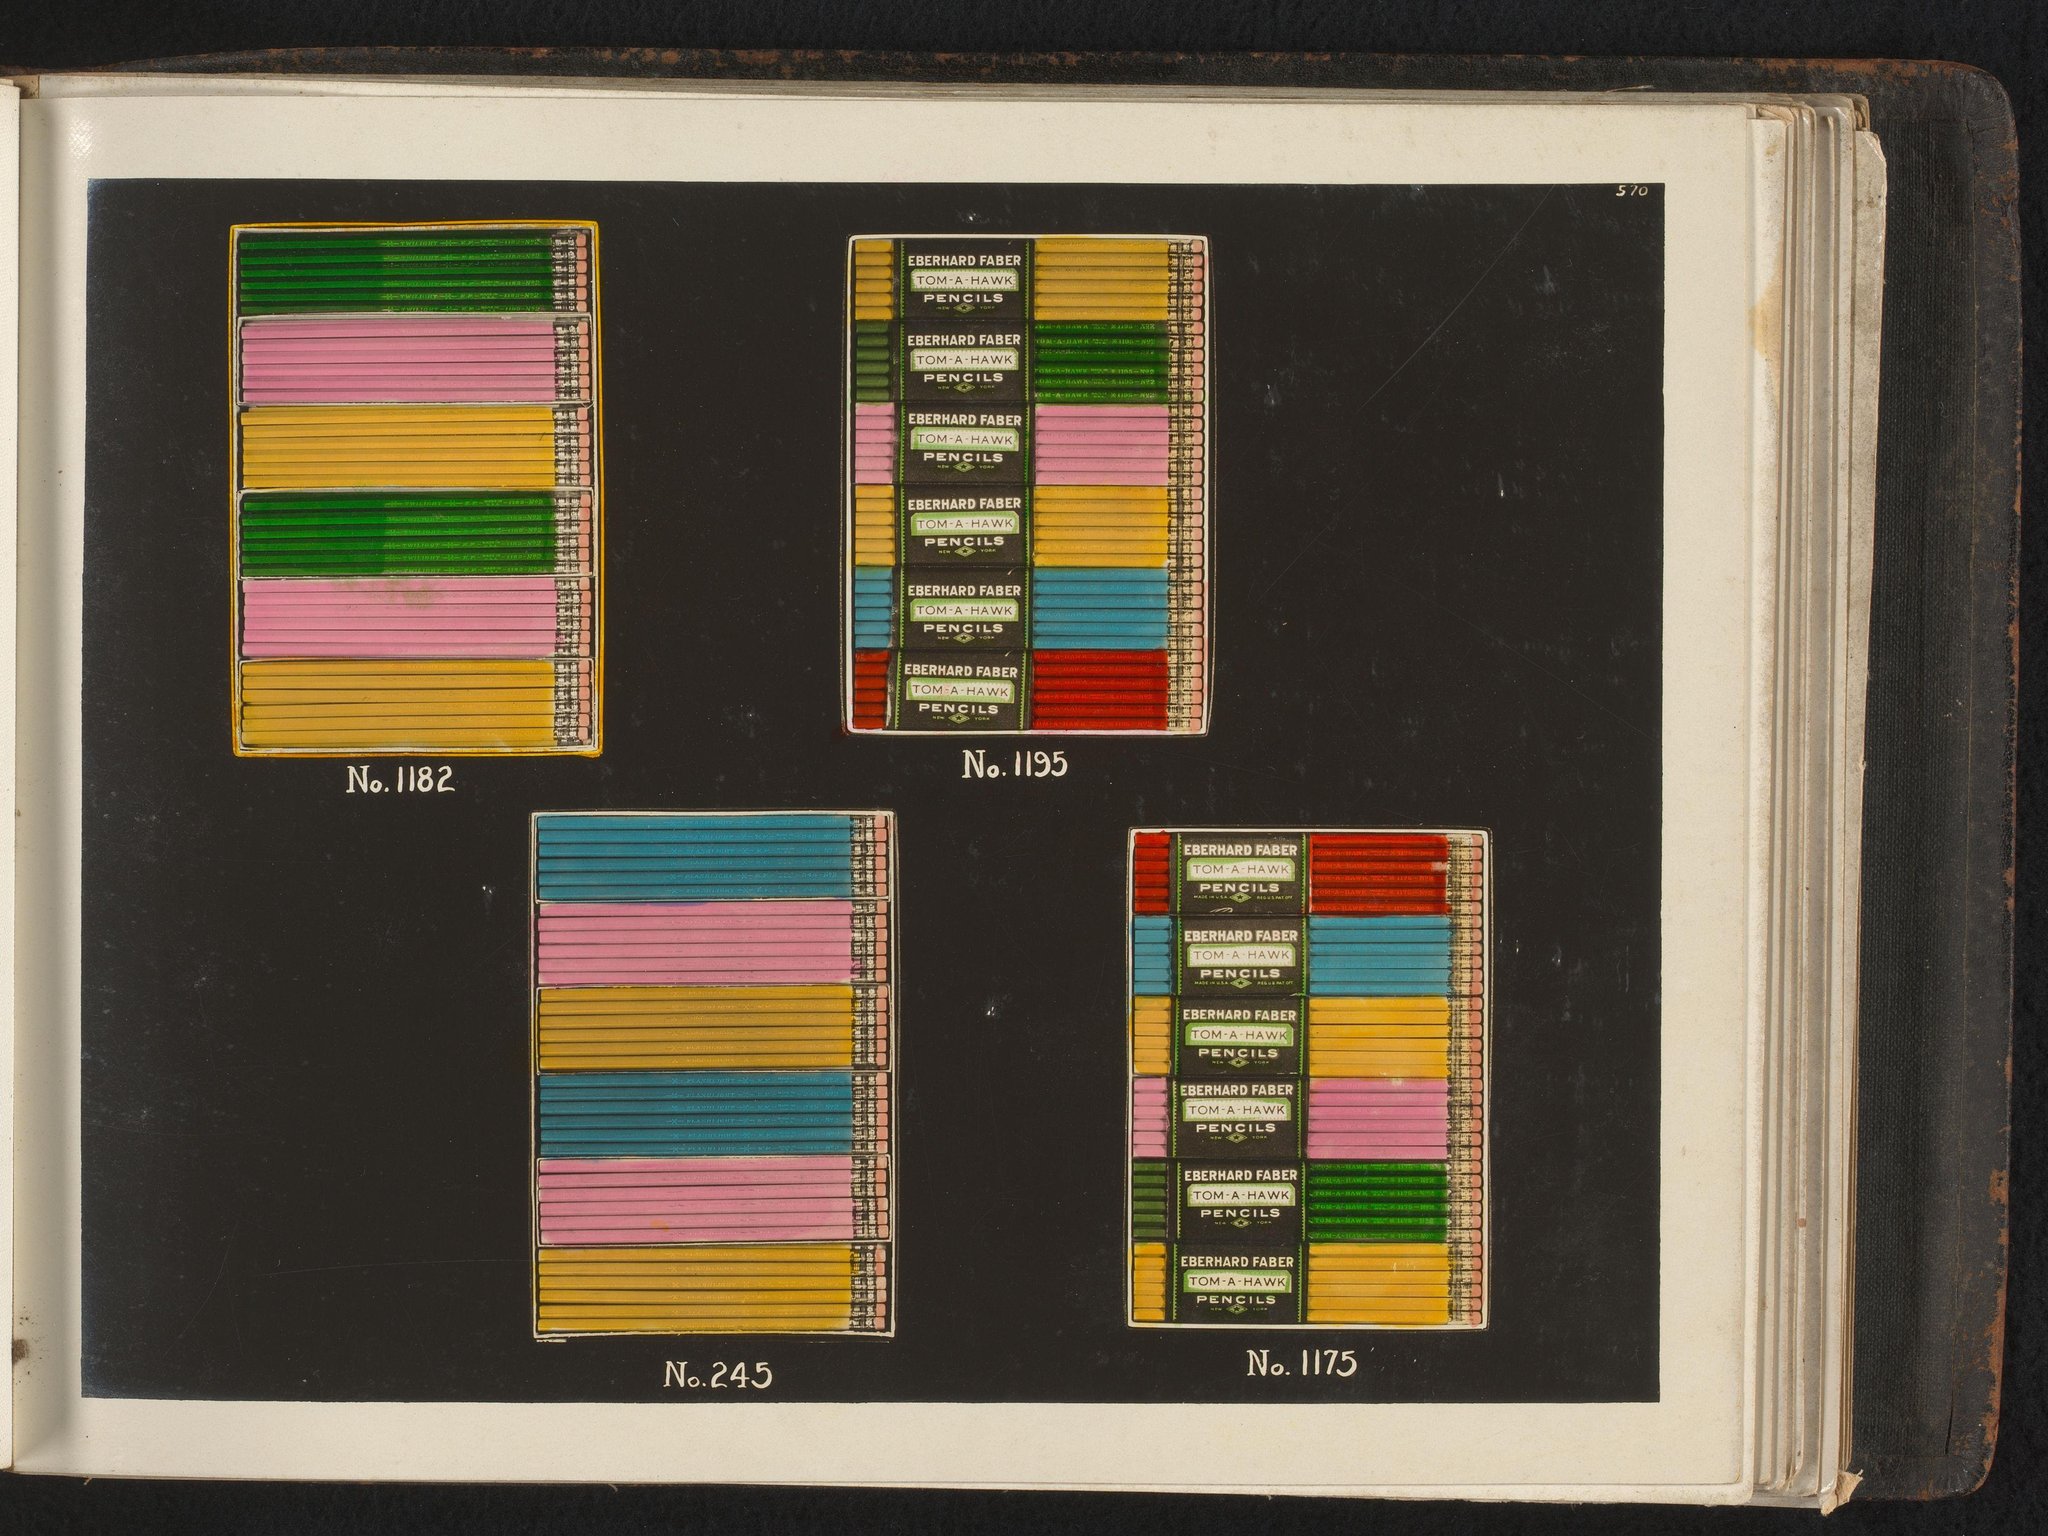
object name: photograph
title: Sets met potloden van Eberhard Faber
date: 1915-1935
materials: paper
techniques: gelatin silver print, hand coloring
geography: springfield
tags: pencil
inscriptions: number: ‘570’, stamp: ‘Paramount/ Commercial Studios/ 145 Chestnut St./ Springfield - Mass.’